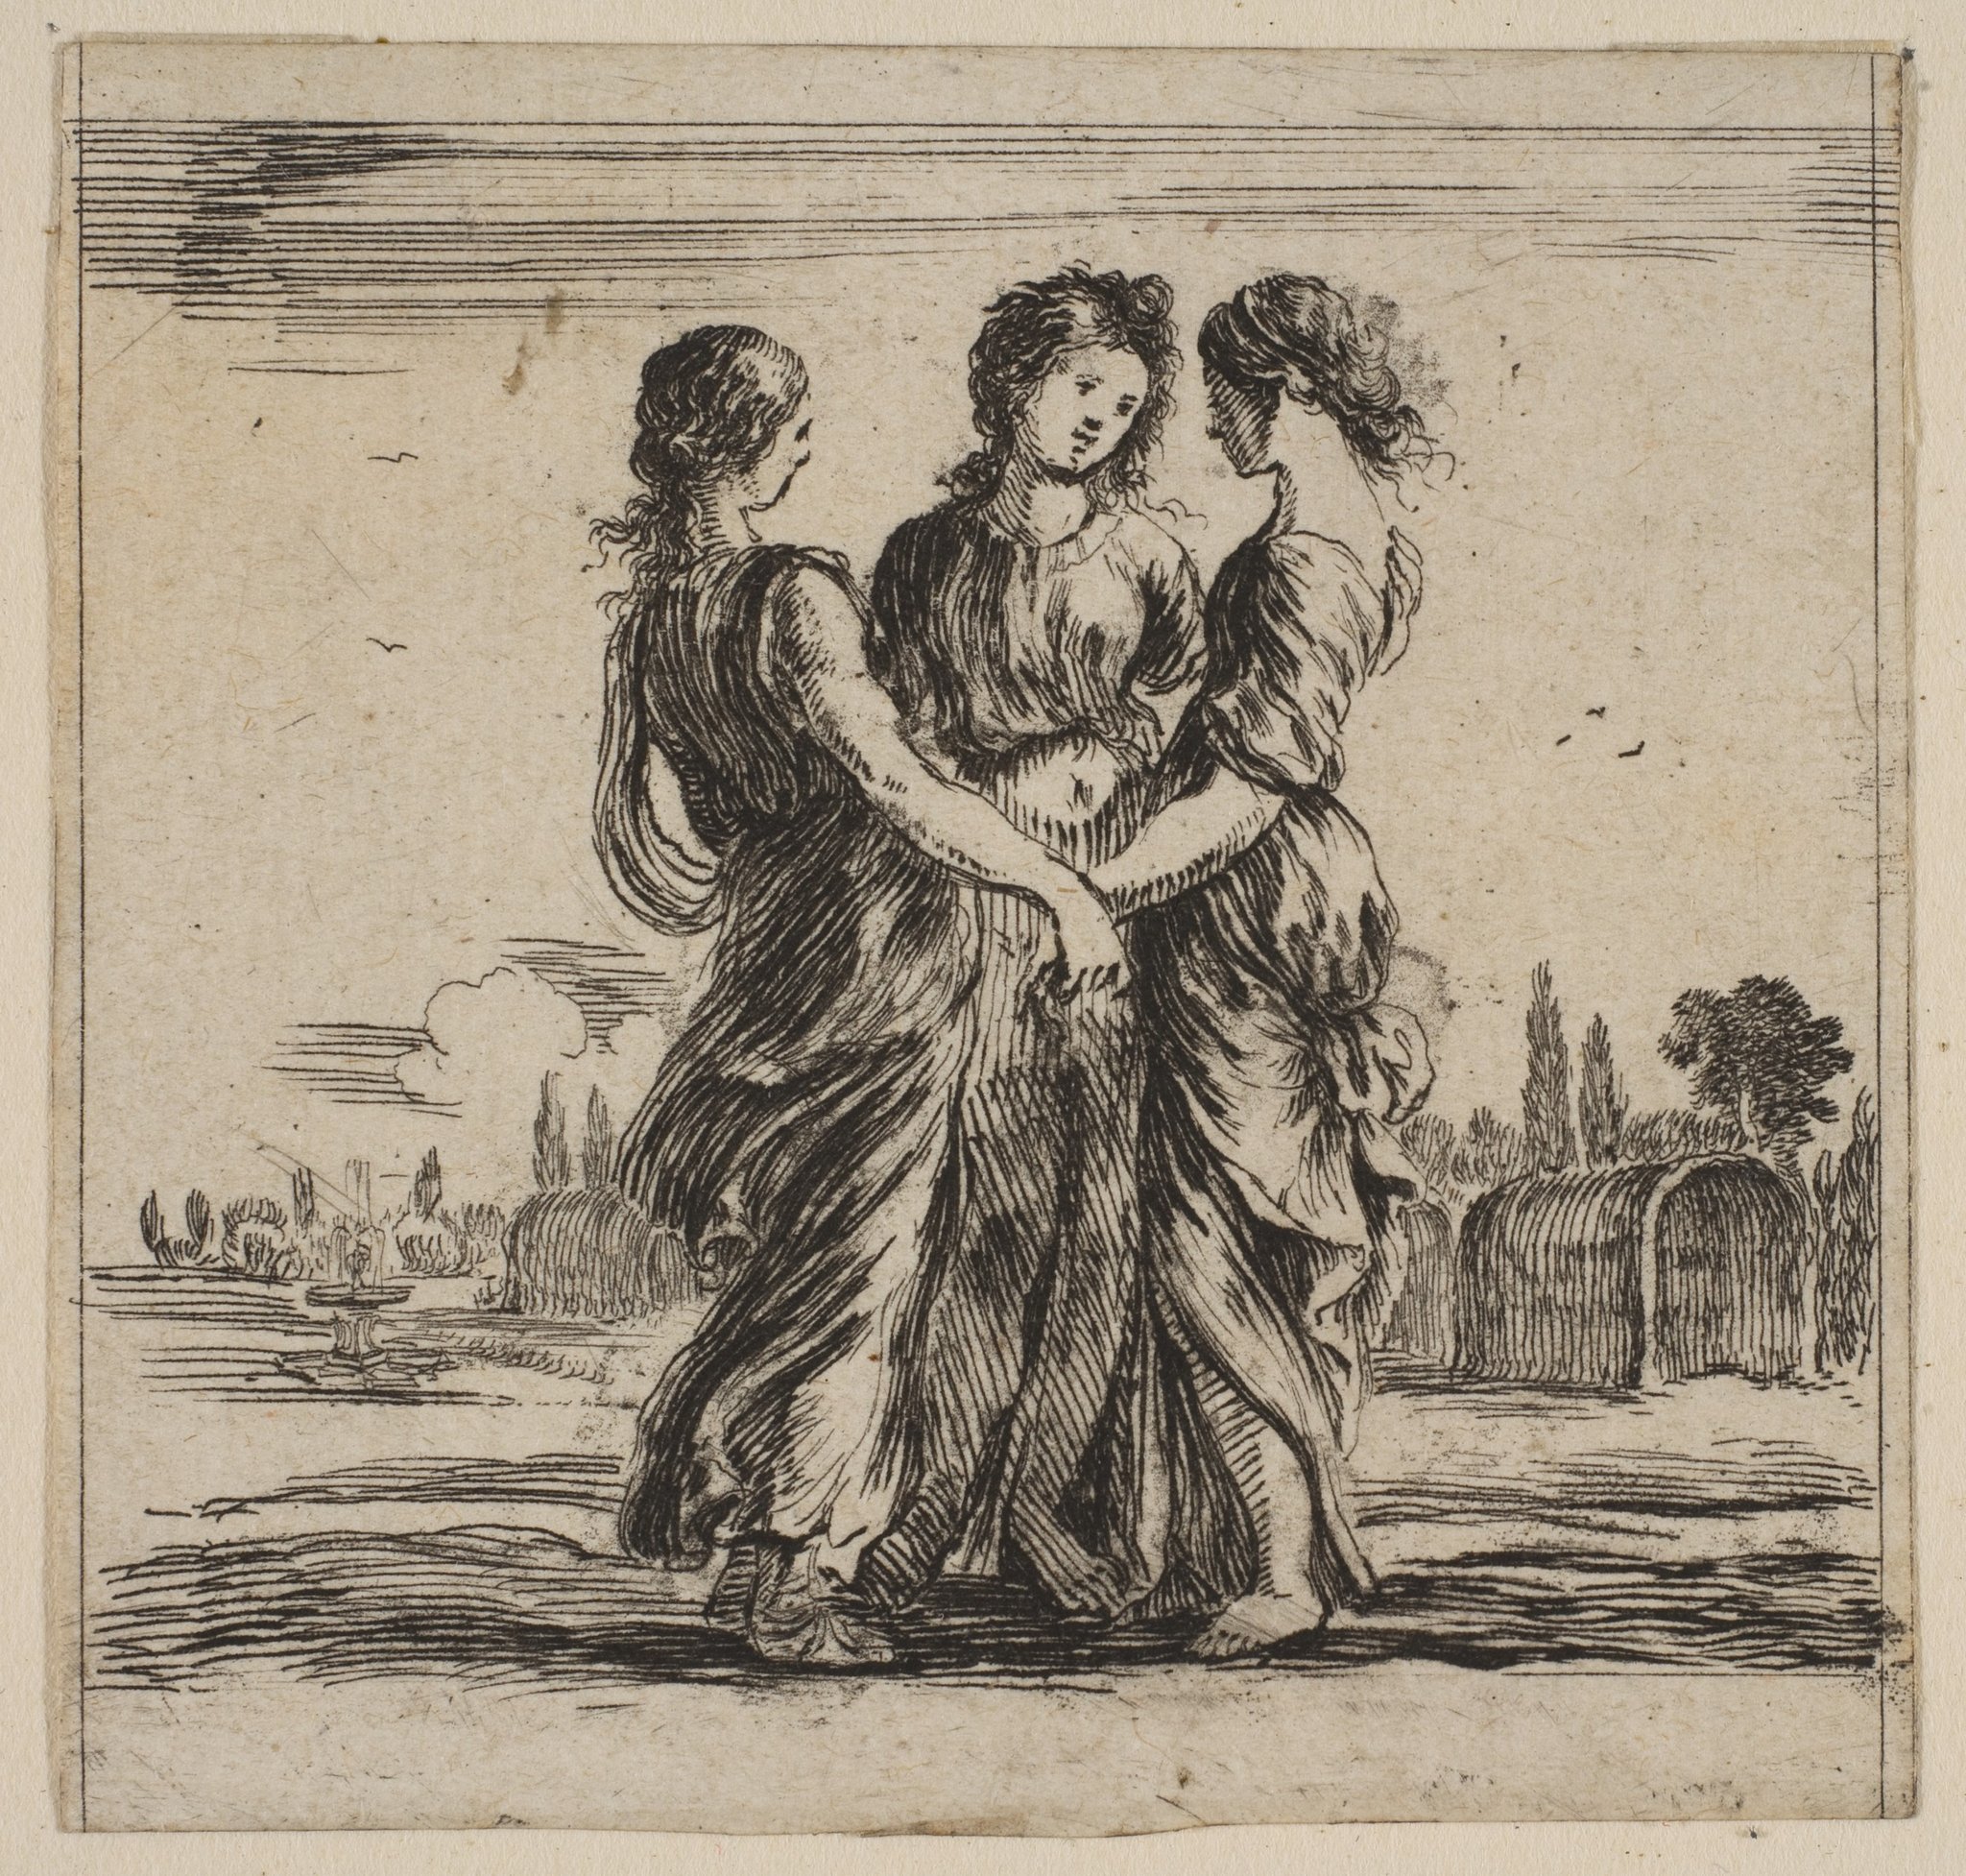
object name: print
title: The three graces, from 'Game of Mythology' (Jeu de la Mythologie)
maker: stefano della bella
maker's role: artist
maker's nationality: italian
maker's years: 1610-1664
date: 1644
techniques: etching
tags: women